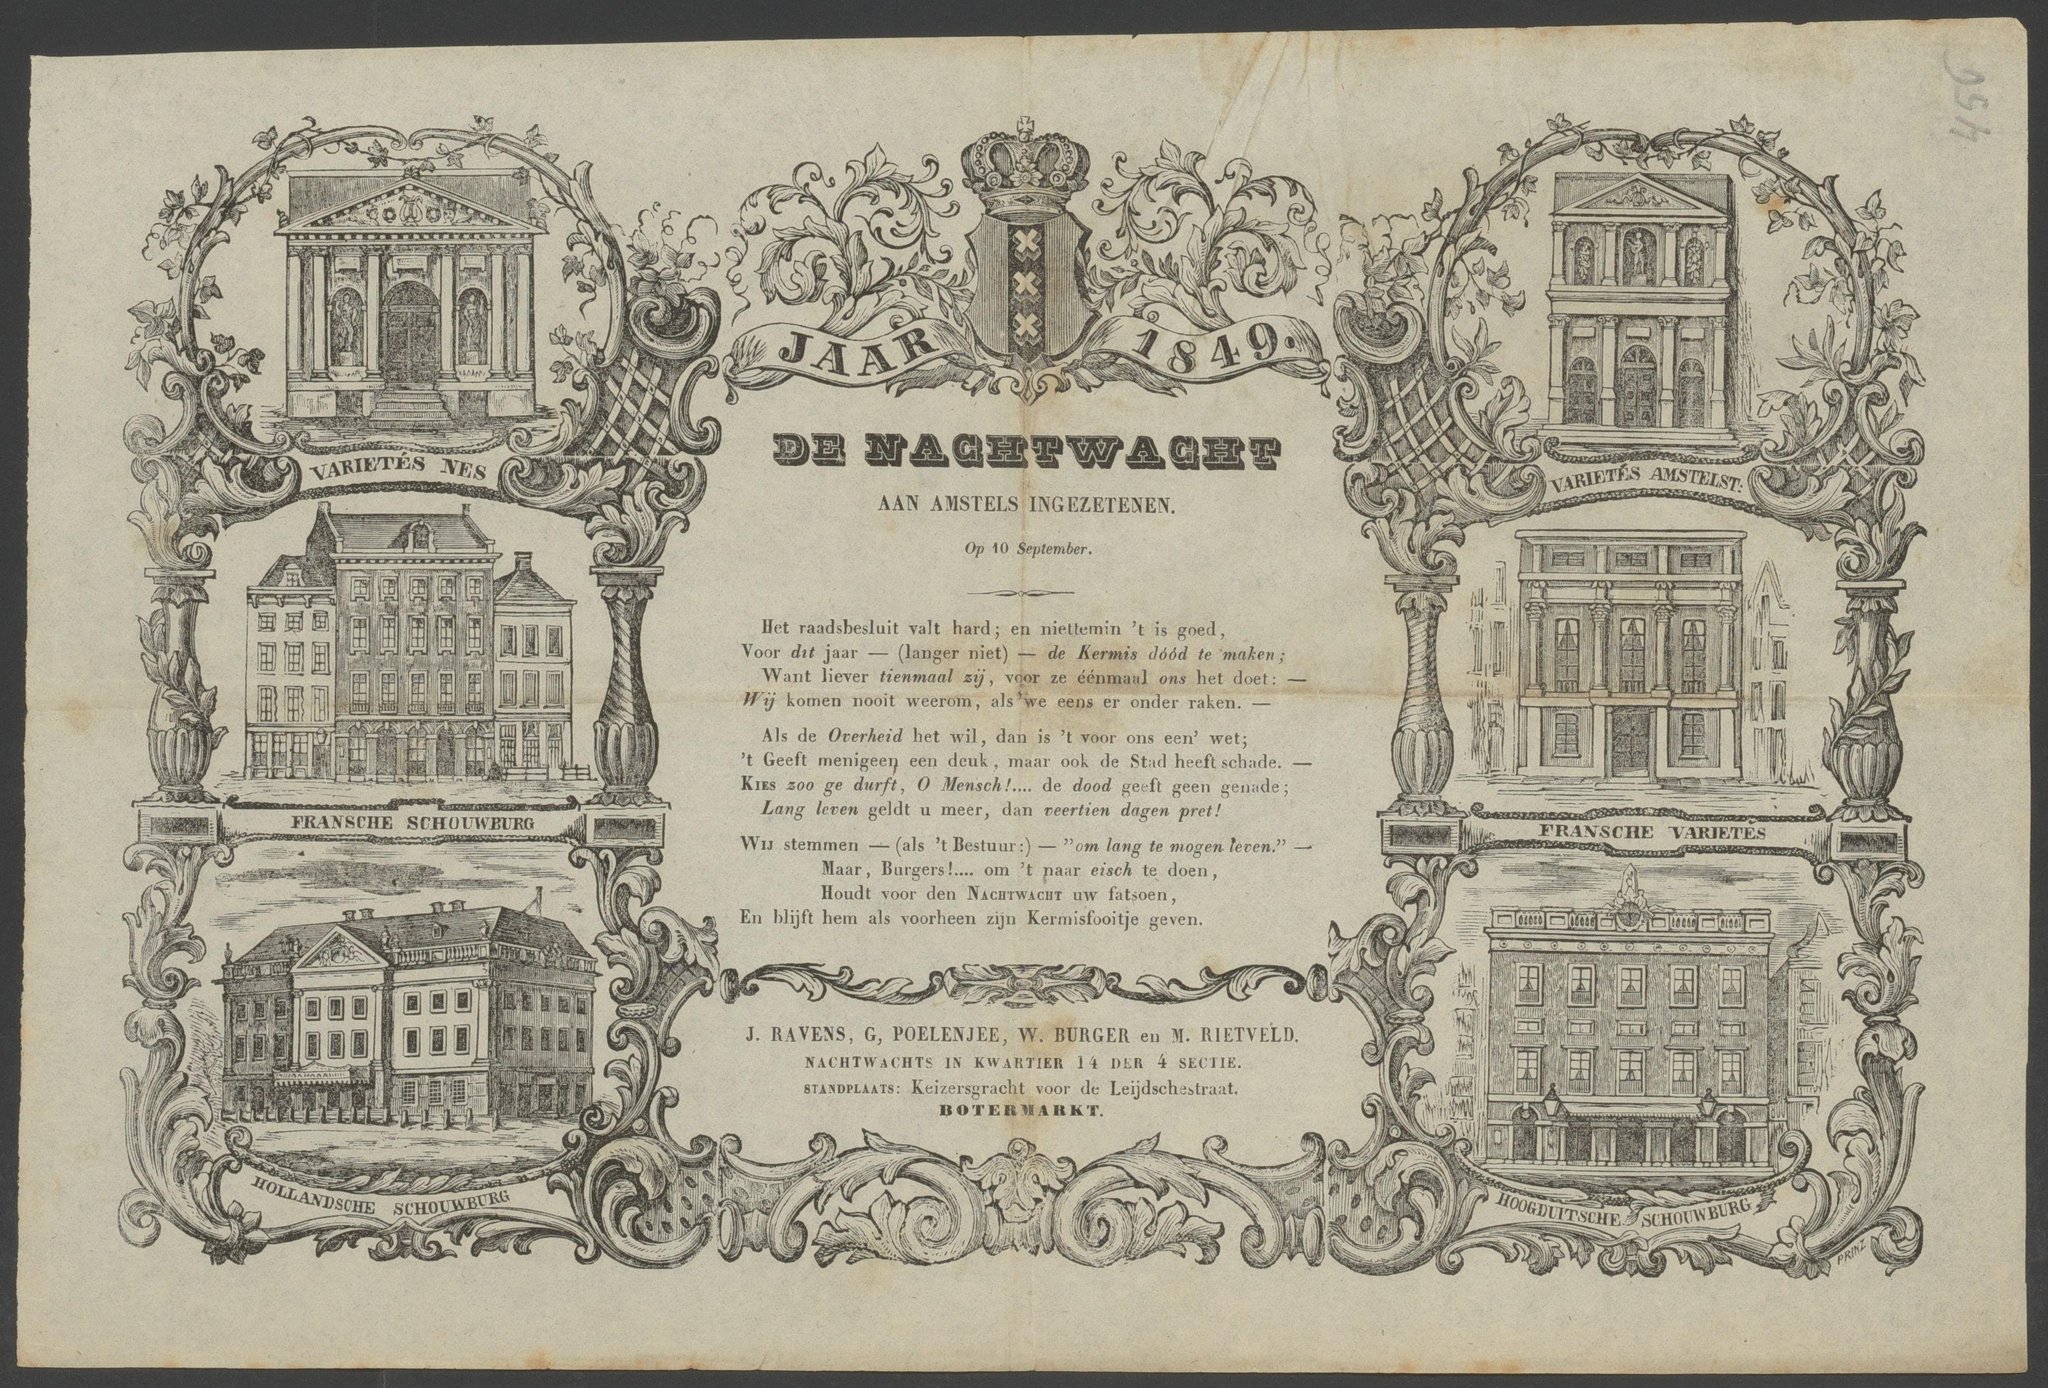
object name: print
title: Kermisprent van de Amsterdamse nachtwacht voor het jaar 1849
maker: friedrich robert prinz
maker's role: print maker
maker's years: 1820-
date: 1849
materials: paper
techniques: letterpress printing, engraving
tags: night patrol, theatre, theatrical performance, amsterdam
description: Kermisprent van de Amsterdamse nachtwacht, 8 september 1848. Centraal een gedicht, aan beide zijde drie Amsterdamse theaters. Door de ratelwachters: J. Ravens, G. Poelenjé, W. Burger en M. Rietveld. Onderwerpsrubrieken binnen de Atlas Zeden en Gewoonten: Zeden en gewoonten in engeren zin, Volksleven, Volksbladen, Nieuwjaars- en Kerstwenschen, Amsterdam.